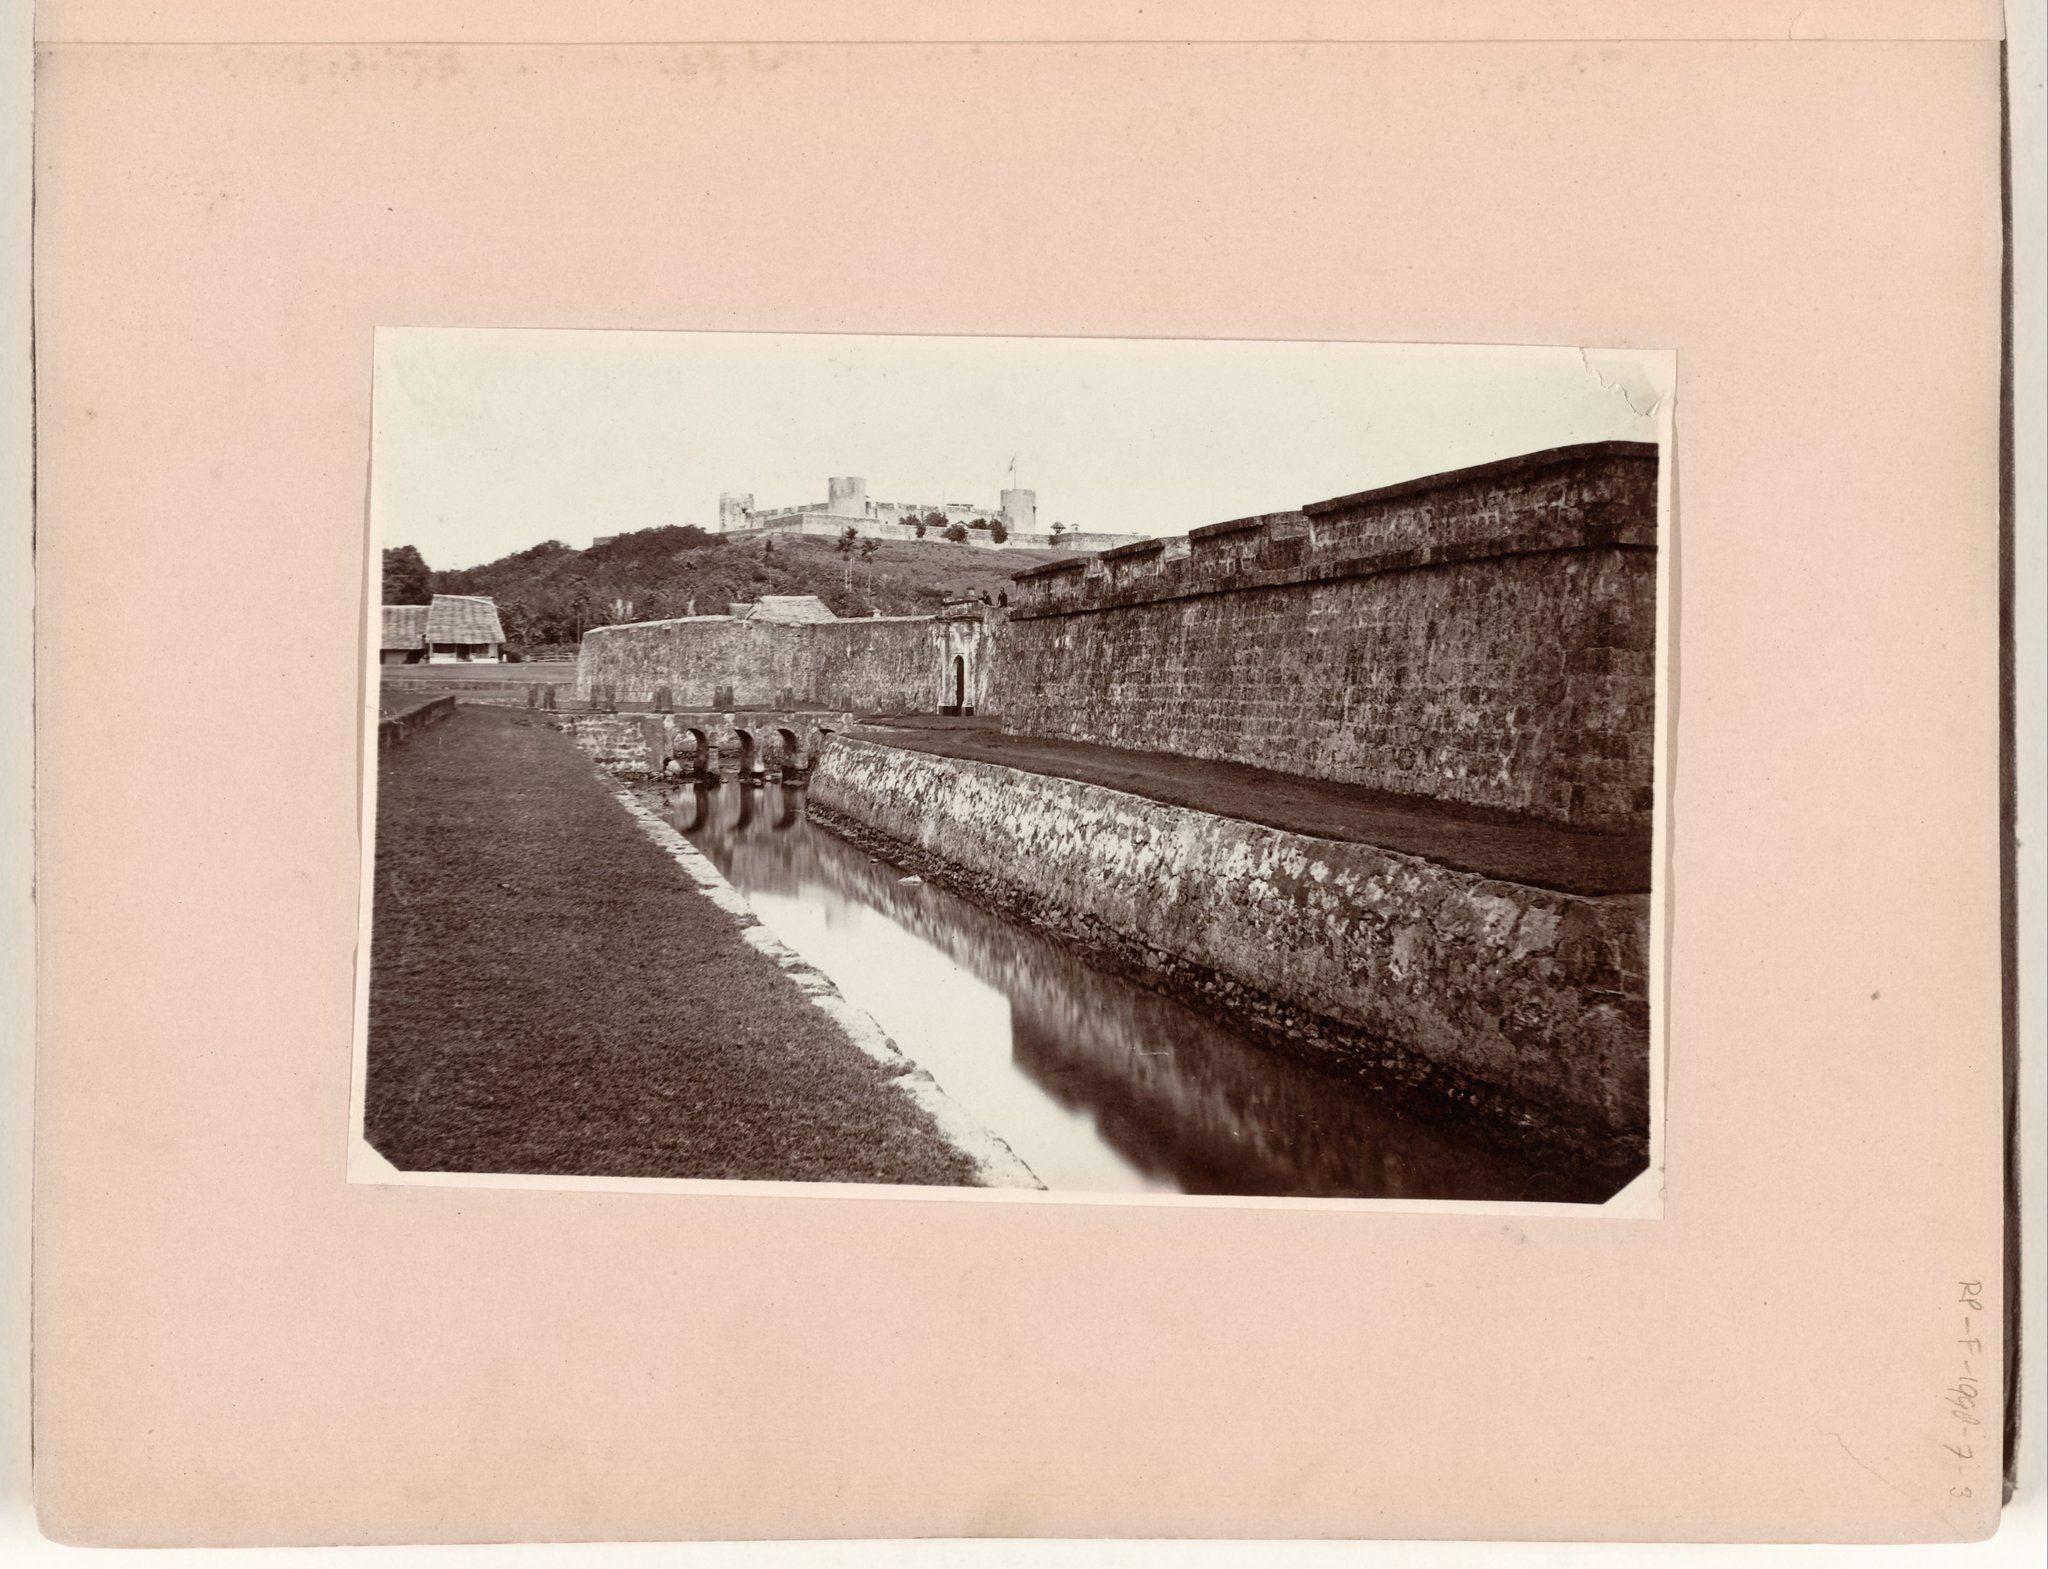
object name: album leaf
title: Fort Nassau en Fort Belgica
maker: c. dietrich (fotograaf)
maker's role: fotograaf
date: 1875-1890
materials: cardboard, paper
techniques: albumen print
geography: banda neira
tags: fortifications, military engineering